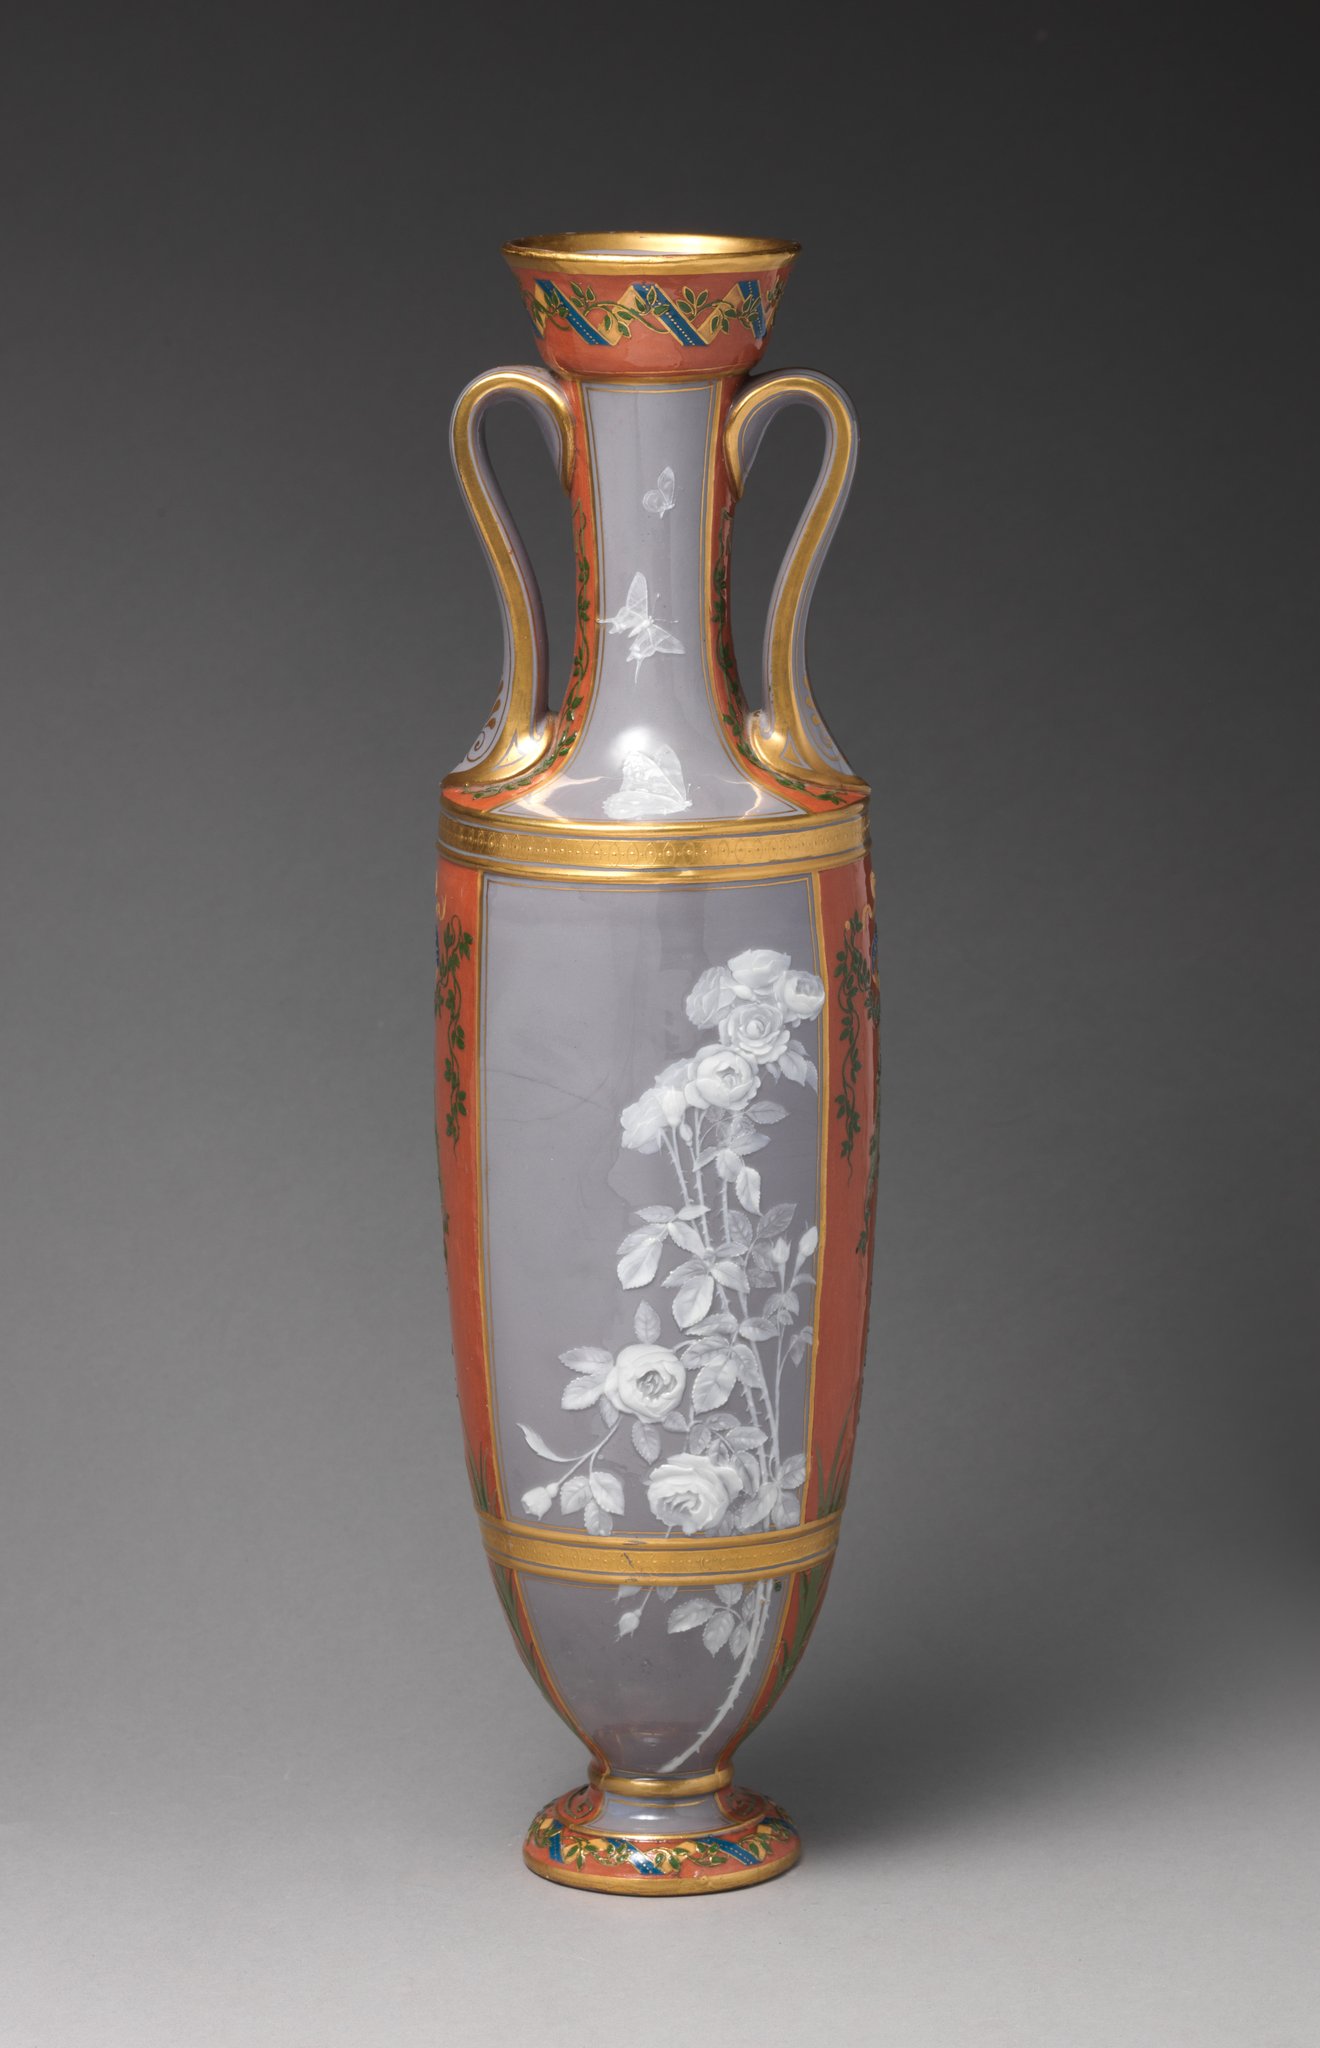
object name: vase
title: Elongated amphora shaped vase in pastel shades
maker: minton(s)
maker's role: maker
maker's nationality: british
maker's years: 1793-2001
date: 1880-1889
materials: porcelain